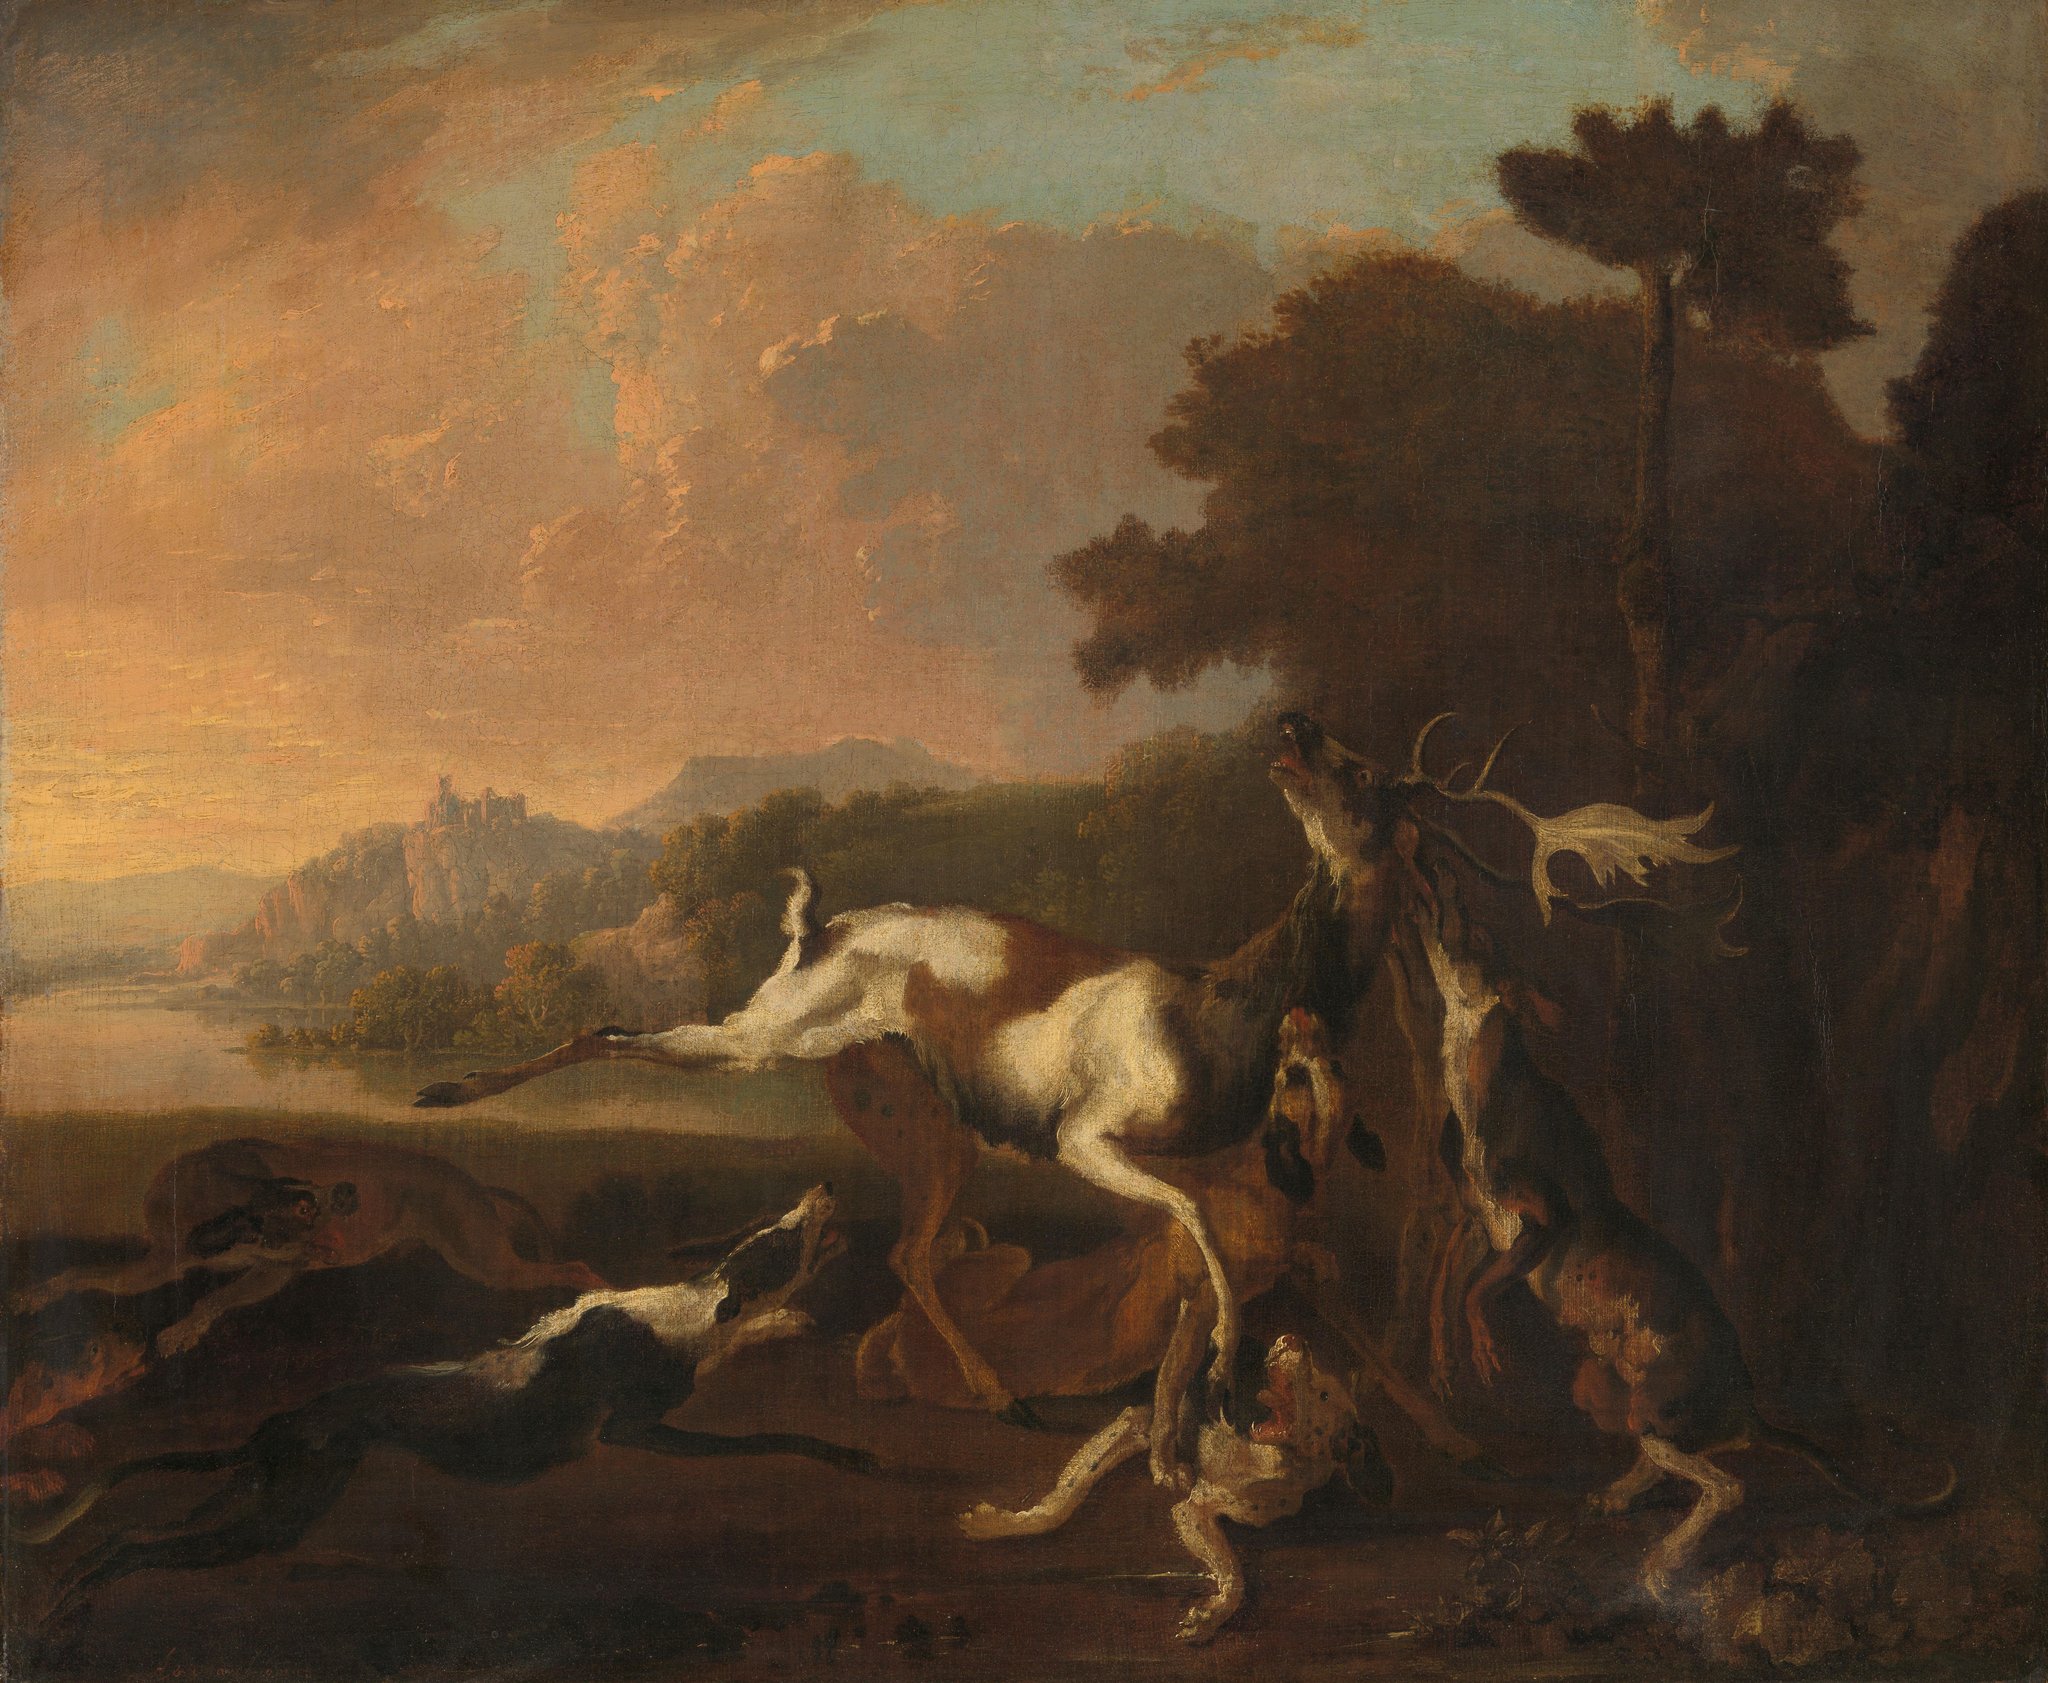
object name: painting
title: The Deer Hunt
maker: abraham daniëlsz. hondius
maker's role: painter, print maker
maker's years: 1625-1691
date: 1650-1695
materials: canvas, oil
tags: stag-hunting, hunting dogs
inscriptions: signature: ‘Abraham Hondius’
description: De hertenjacht. Een meute jachthonden valt een hert aan. Op de achtergrond een rivierlandschap.